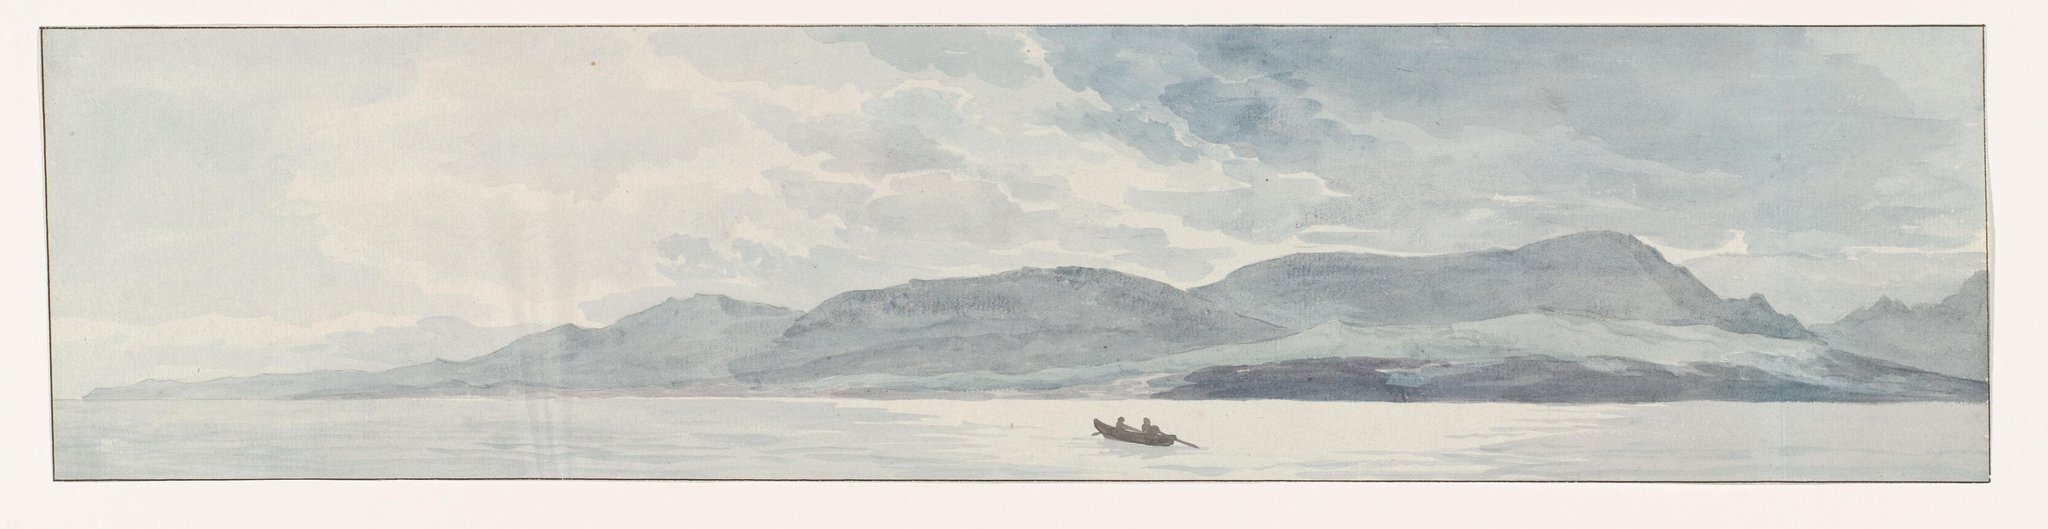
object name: watercolor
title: Gezicht op de kaap van Bruzzano en de punt van kaap Spartivento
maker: louis ducros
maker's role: draughtsman, print maker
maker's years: 1748-1810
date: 1778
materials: chalk, paper, watercolor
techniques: brush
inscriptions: number: ‘No 124 Vue du Cap di Burzano & de la pointe du Cap di Spartivento’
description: Tekening uit het album 'Voyage en Italie, en Sicile et à Malte', 1778.